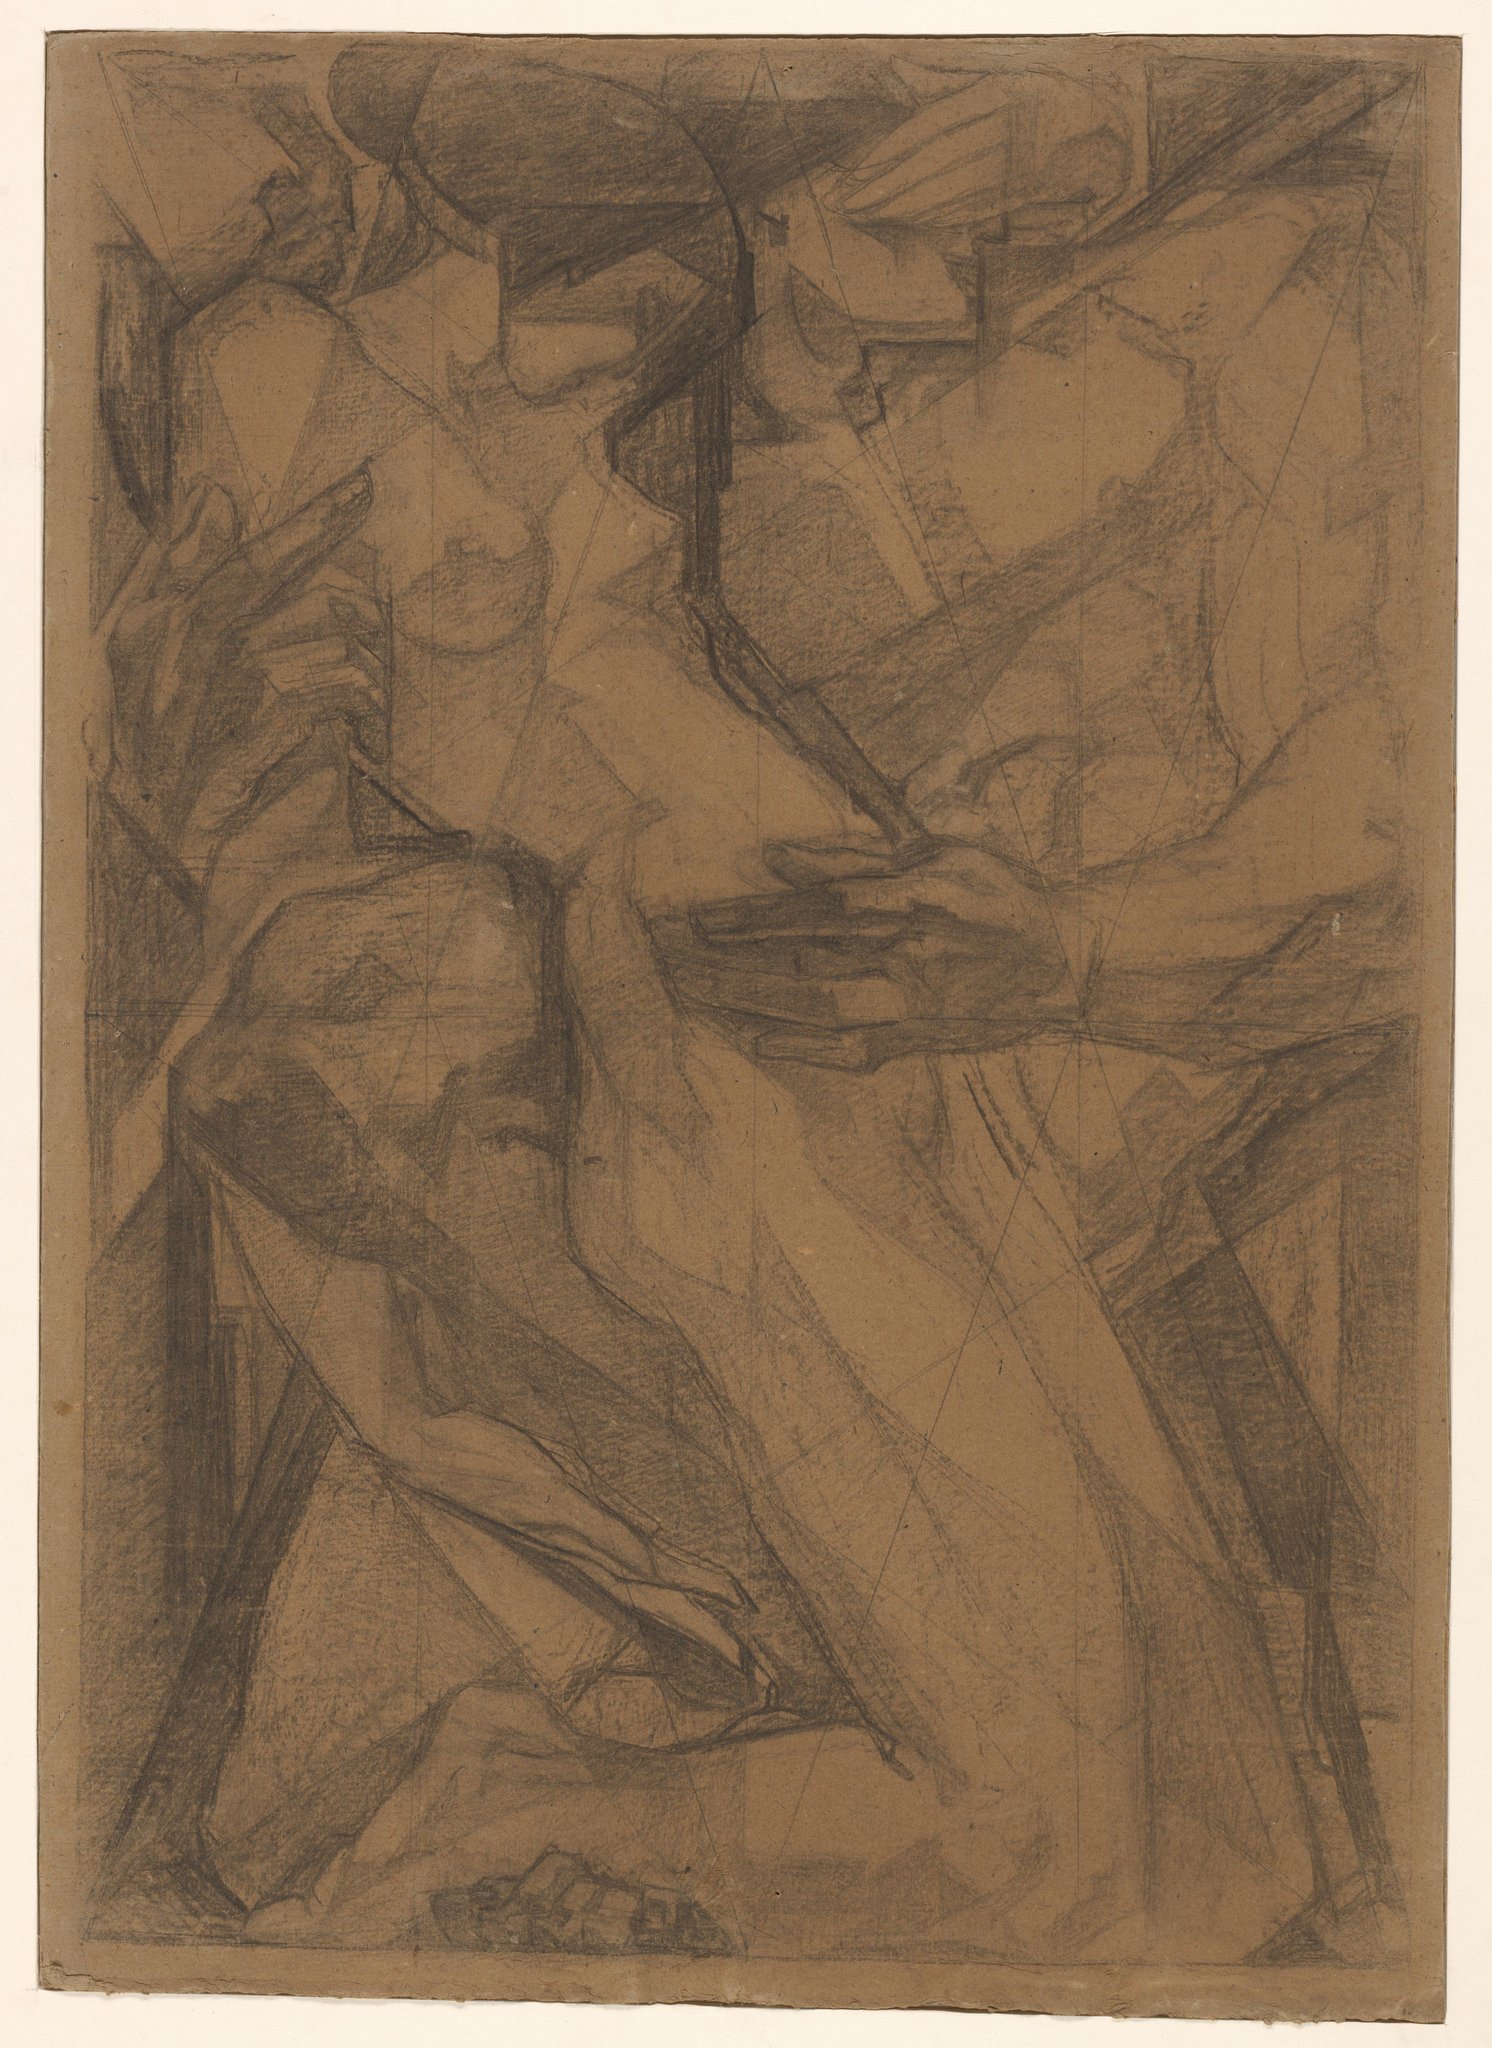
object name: drawing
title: Naakte vrouw wordt omarmd door een gespierde naakte man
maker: reijer stolk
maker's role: draughtsman, print maker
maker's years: 1896-1945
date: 1906-1945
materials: cardboard, charcoal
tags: nude with covered genitals, nude with covered genitals - aa - female human figure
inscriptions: collector's mark: Lugt 2228